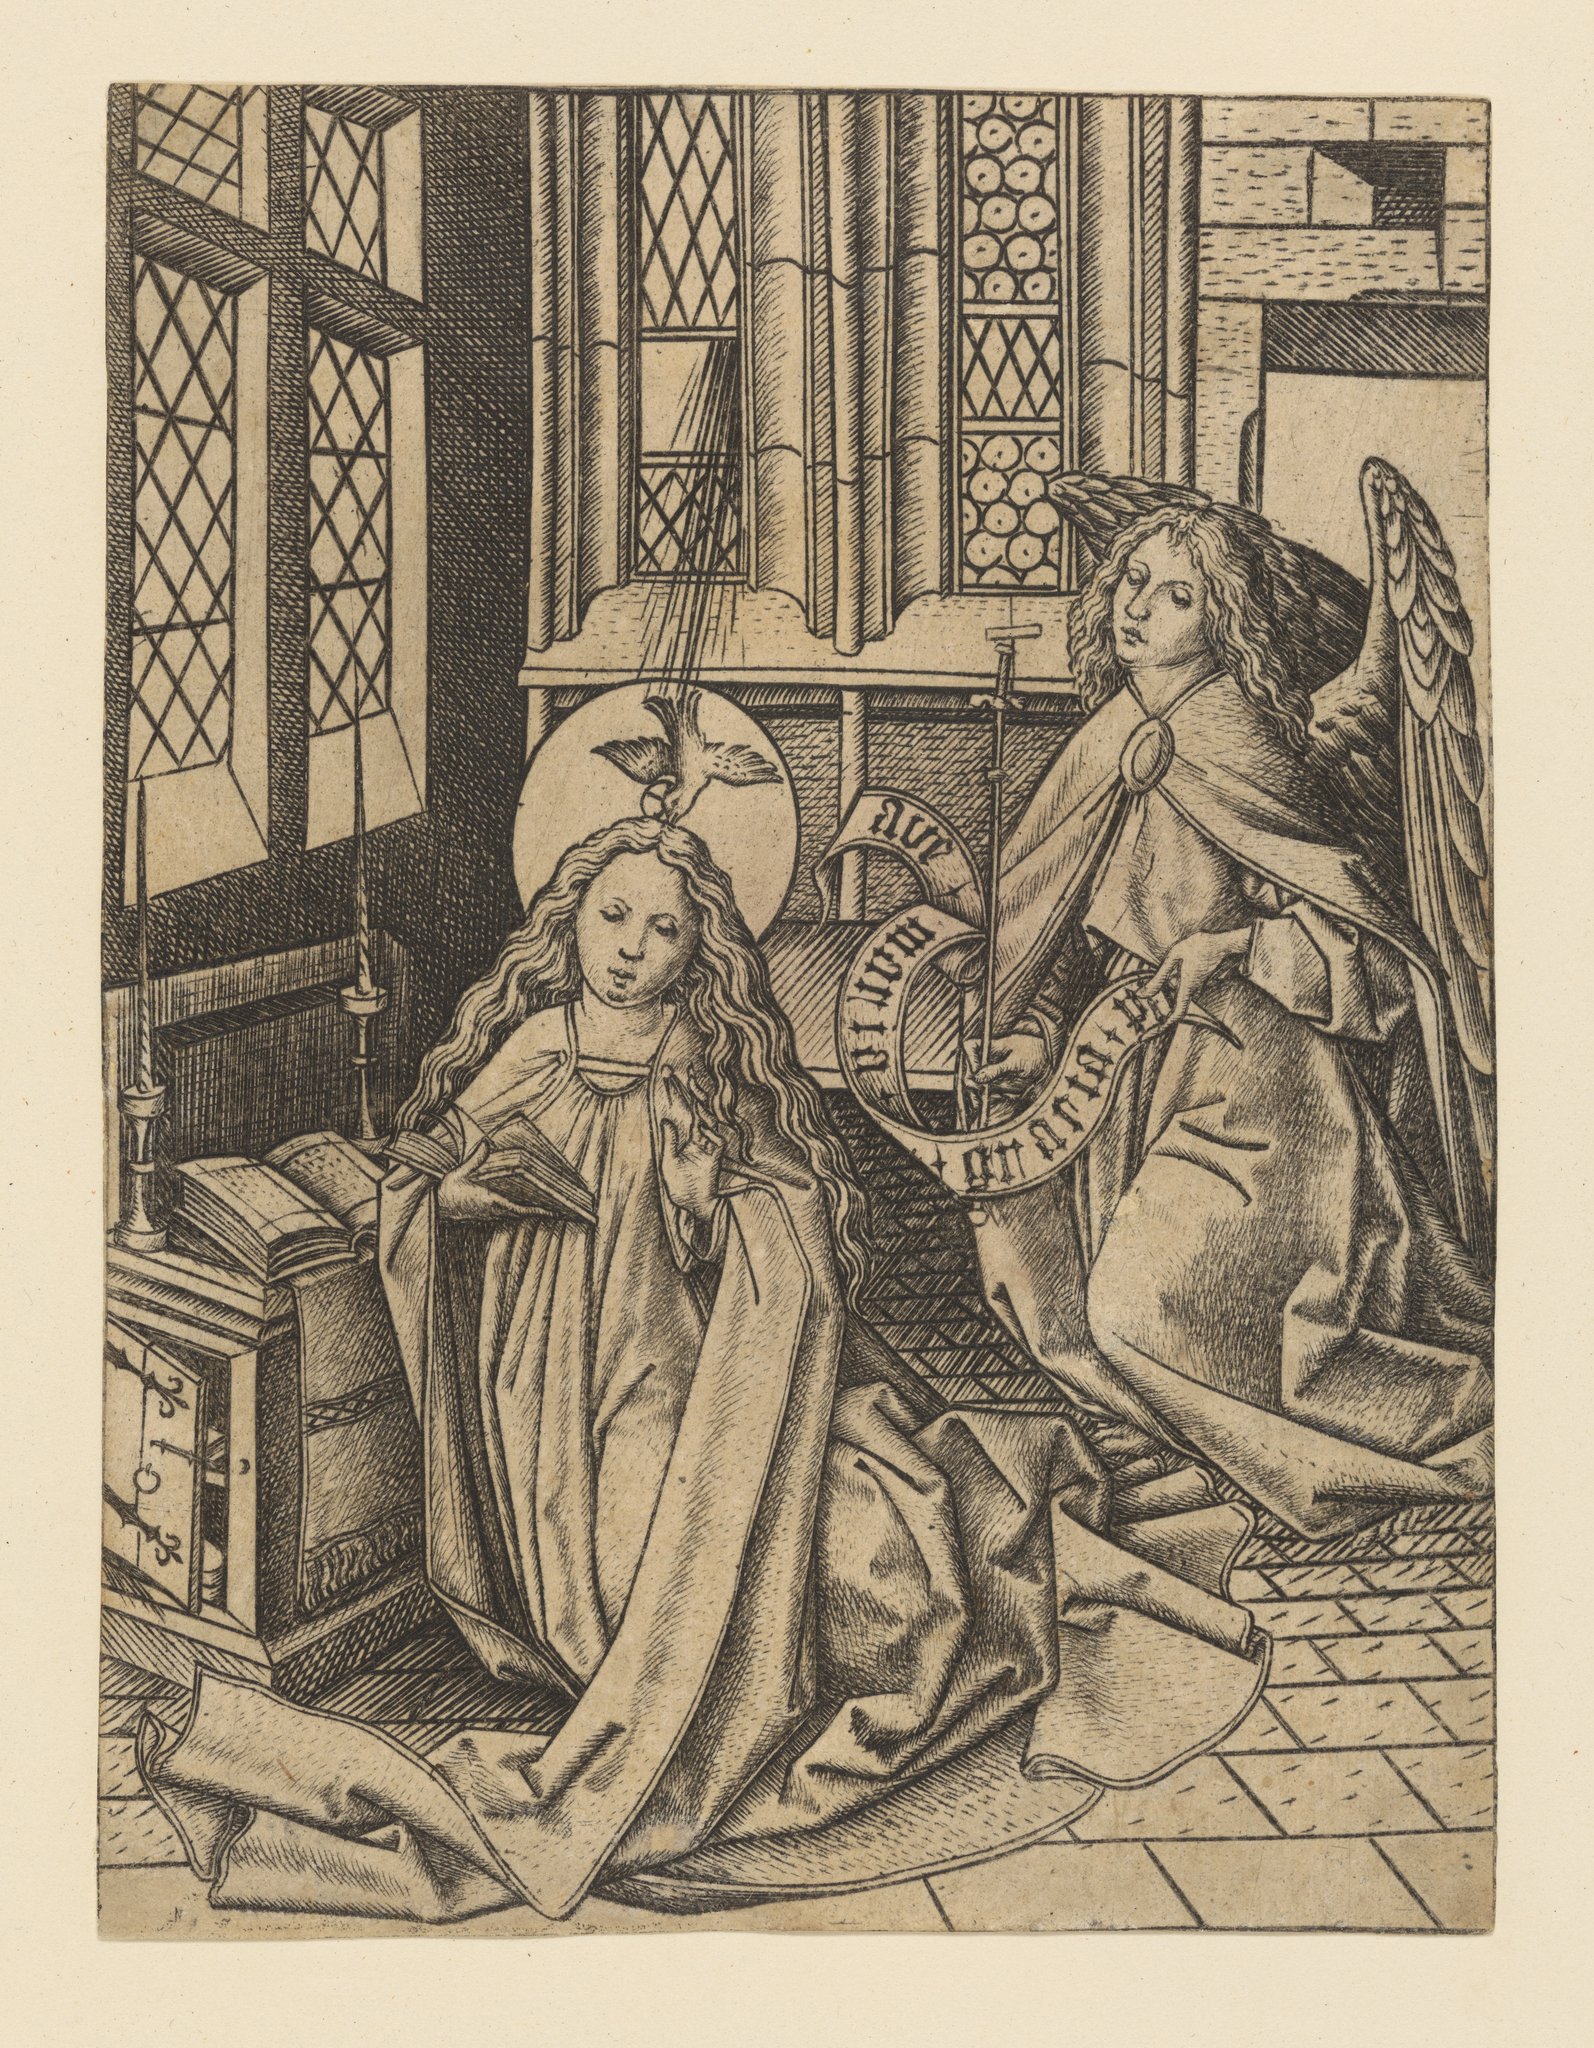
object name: print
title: The Annunciation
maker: master es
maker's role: artist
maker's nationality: german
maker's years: 1445-1467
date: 1434-1466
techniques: engraving